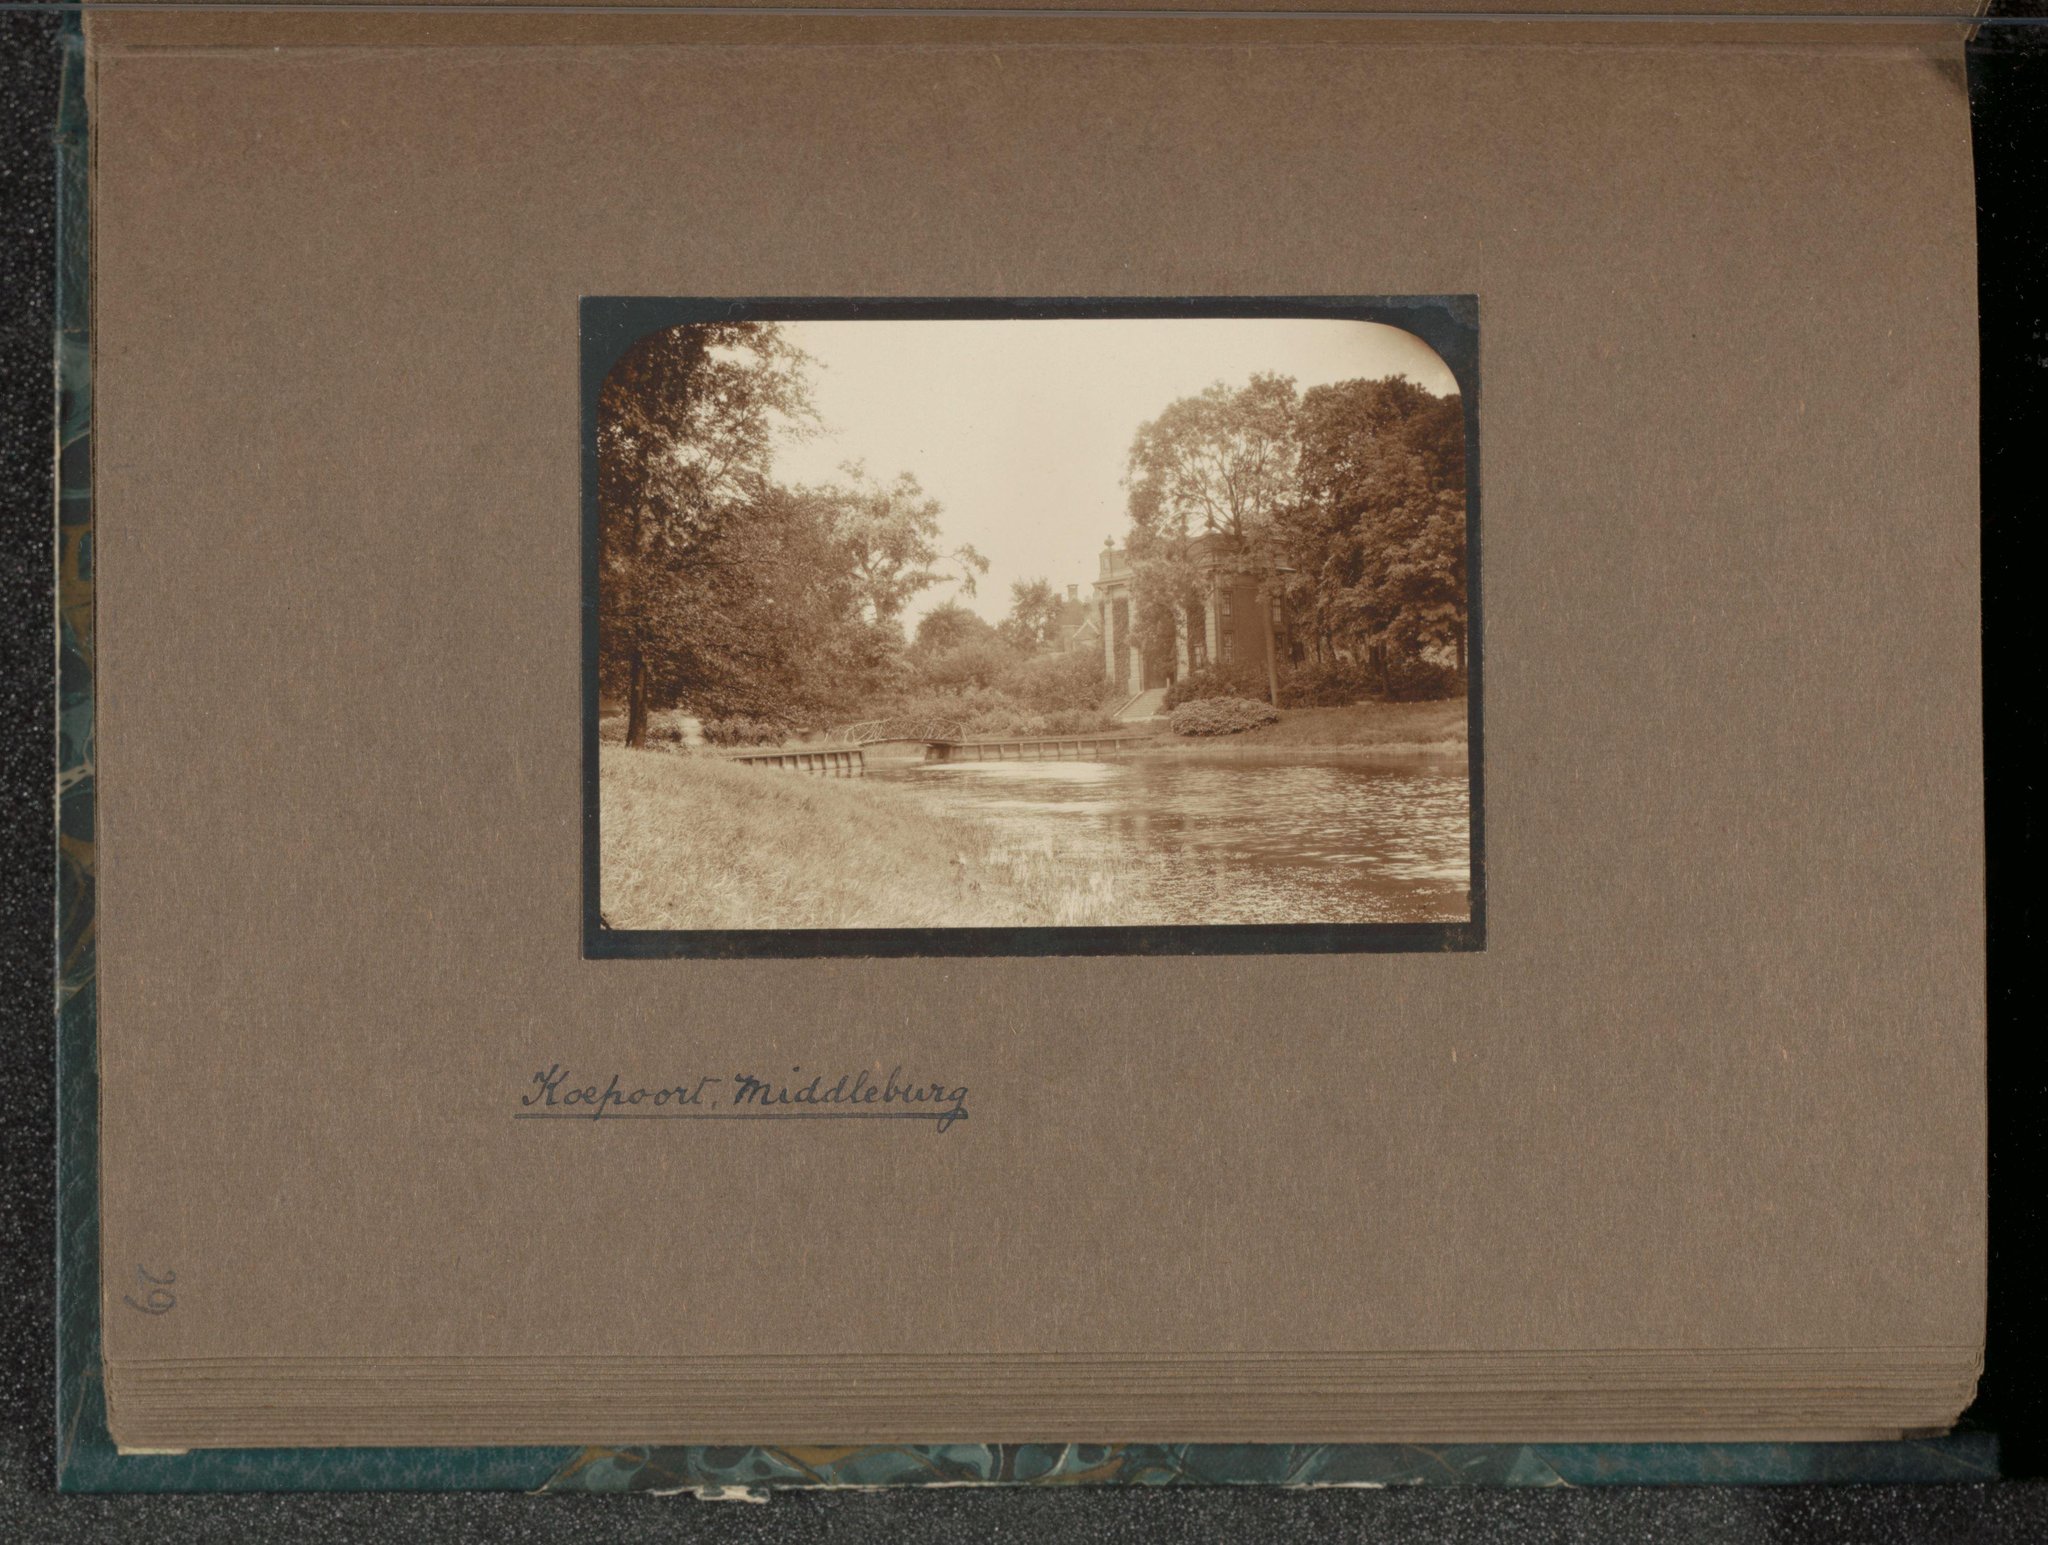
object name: photograph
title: Koepoort Middleburg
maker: Anonymous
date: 1912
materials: photographic support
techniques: gelatin silver print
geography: middelburg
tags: gate, entrance, canals, waters (in city), travelling; tourism, middelburg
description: Onderdeel van Fotoalbum van de excursie naar Nederland van de Britse amateurfotografenvereniging P.C.U.K.